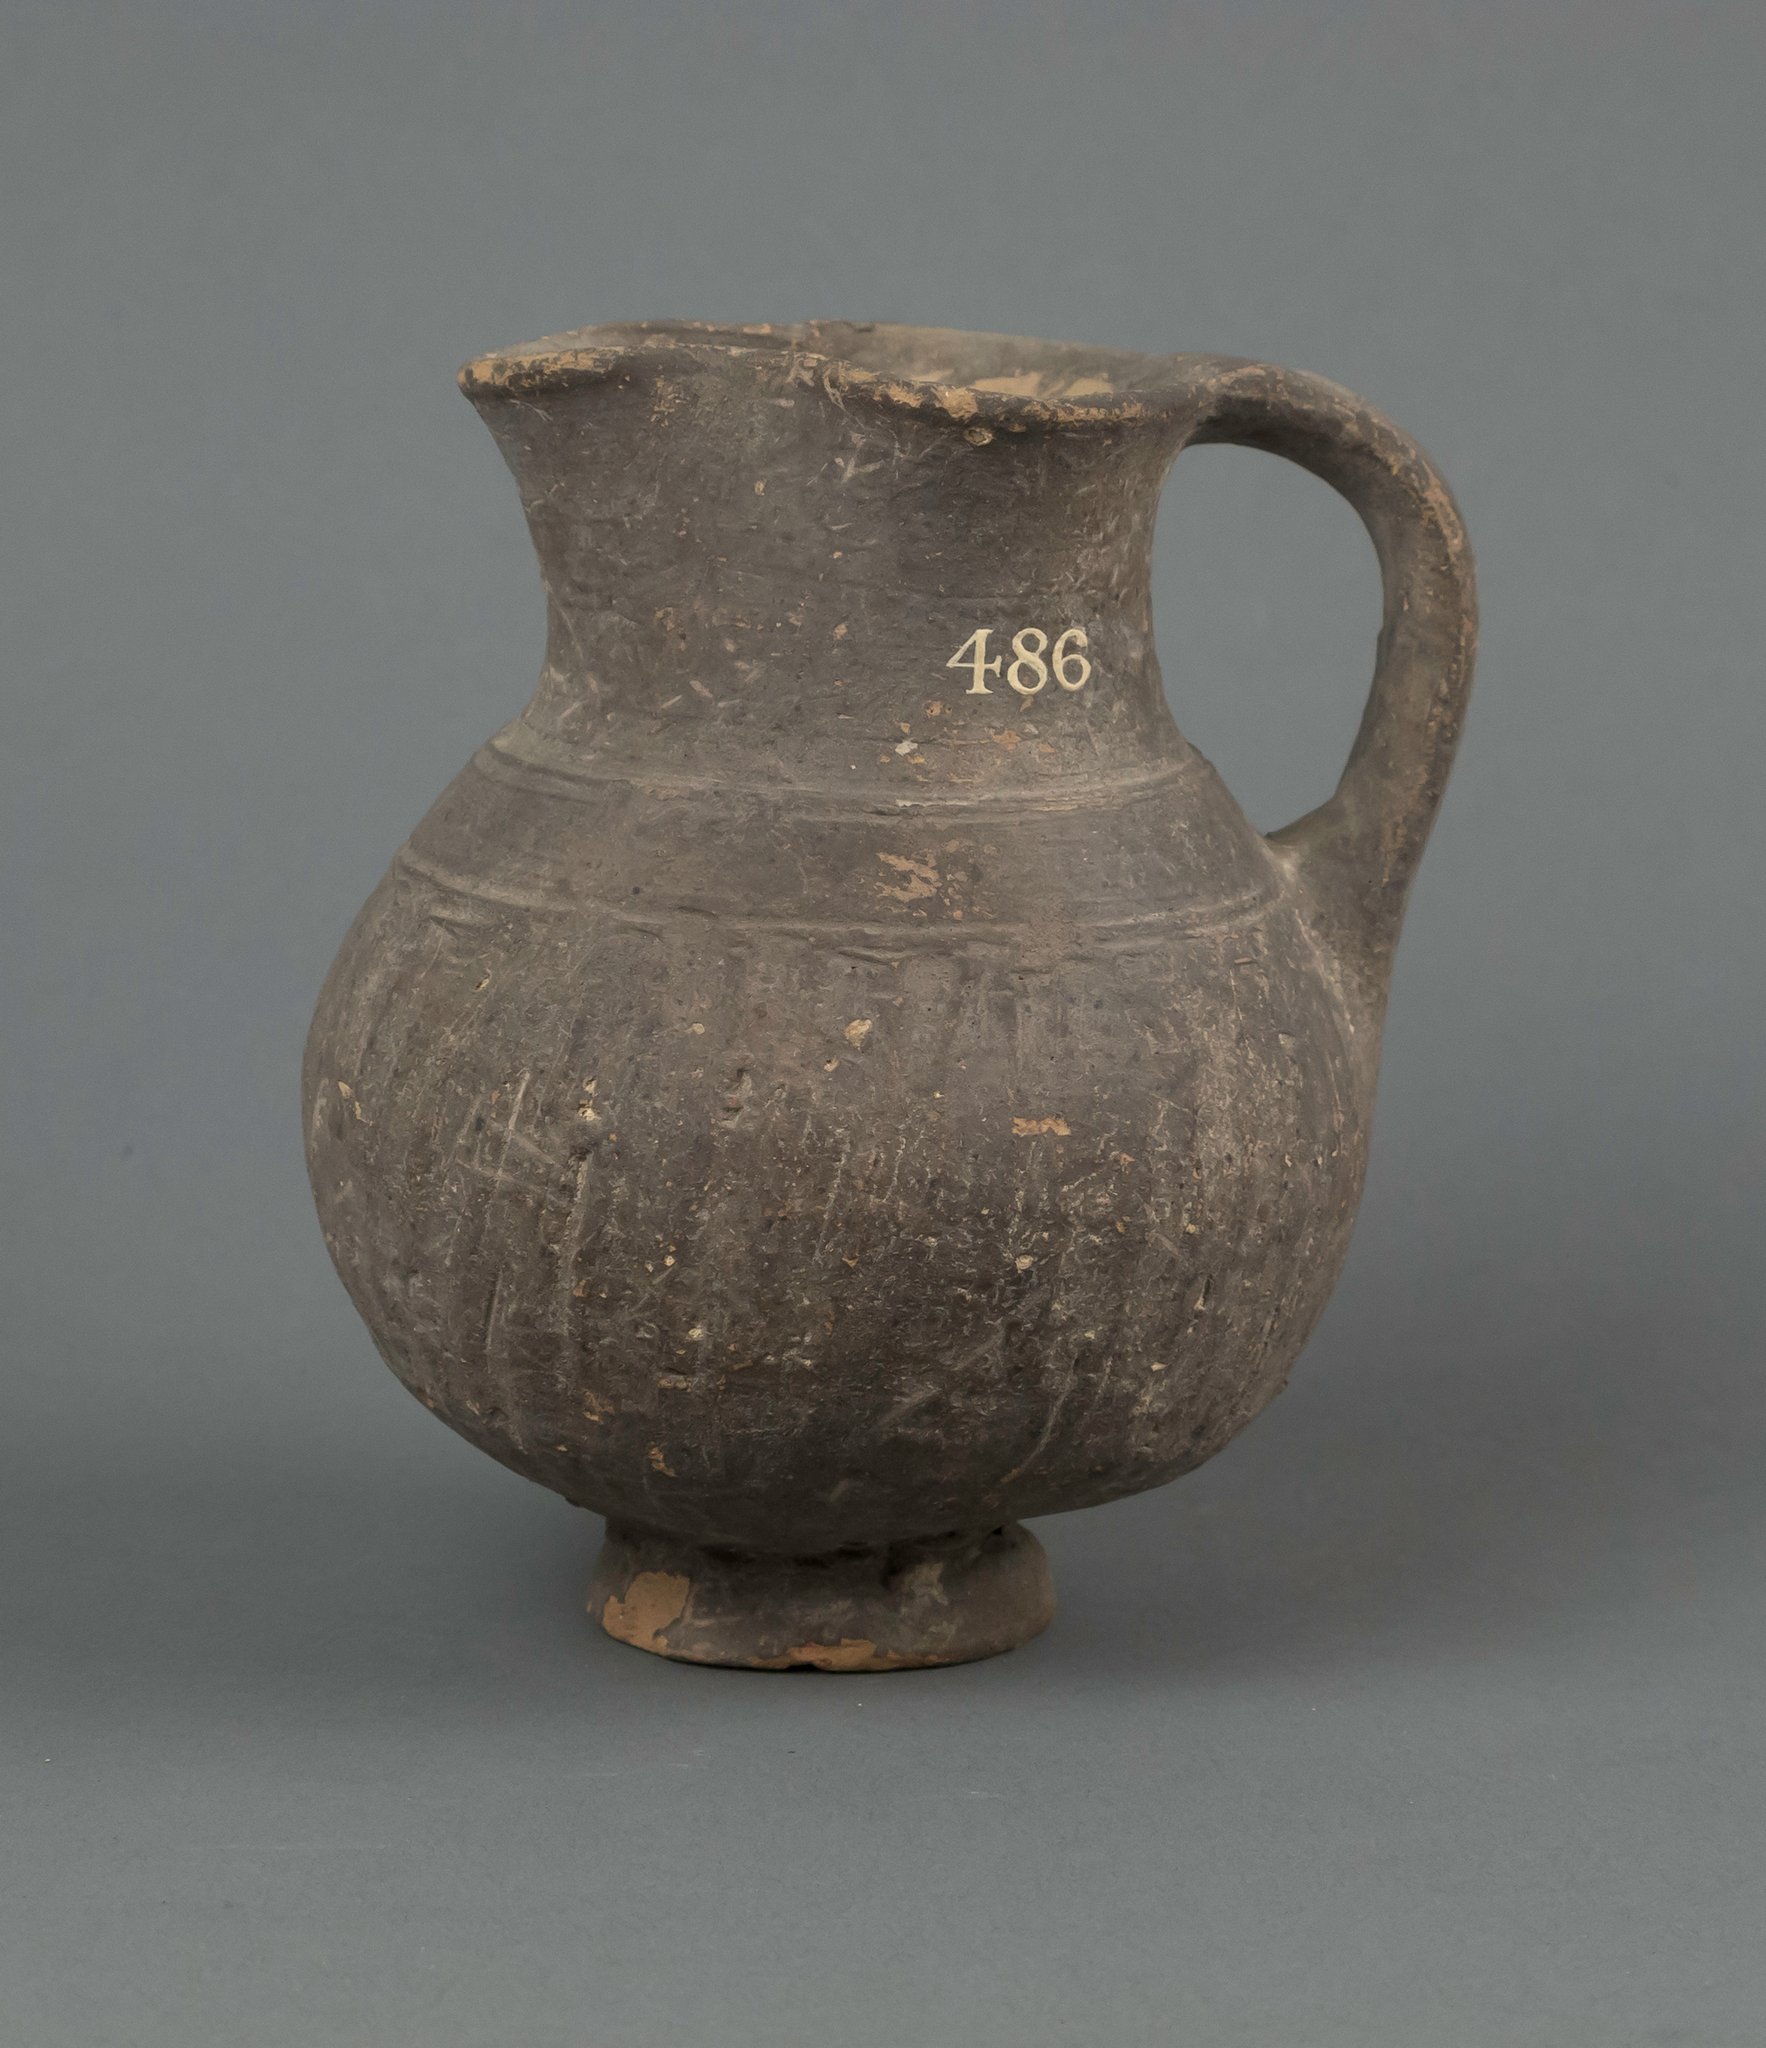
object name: juglet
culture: cypriot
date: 1050-950 BCE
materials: terracotta